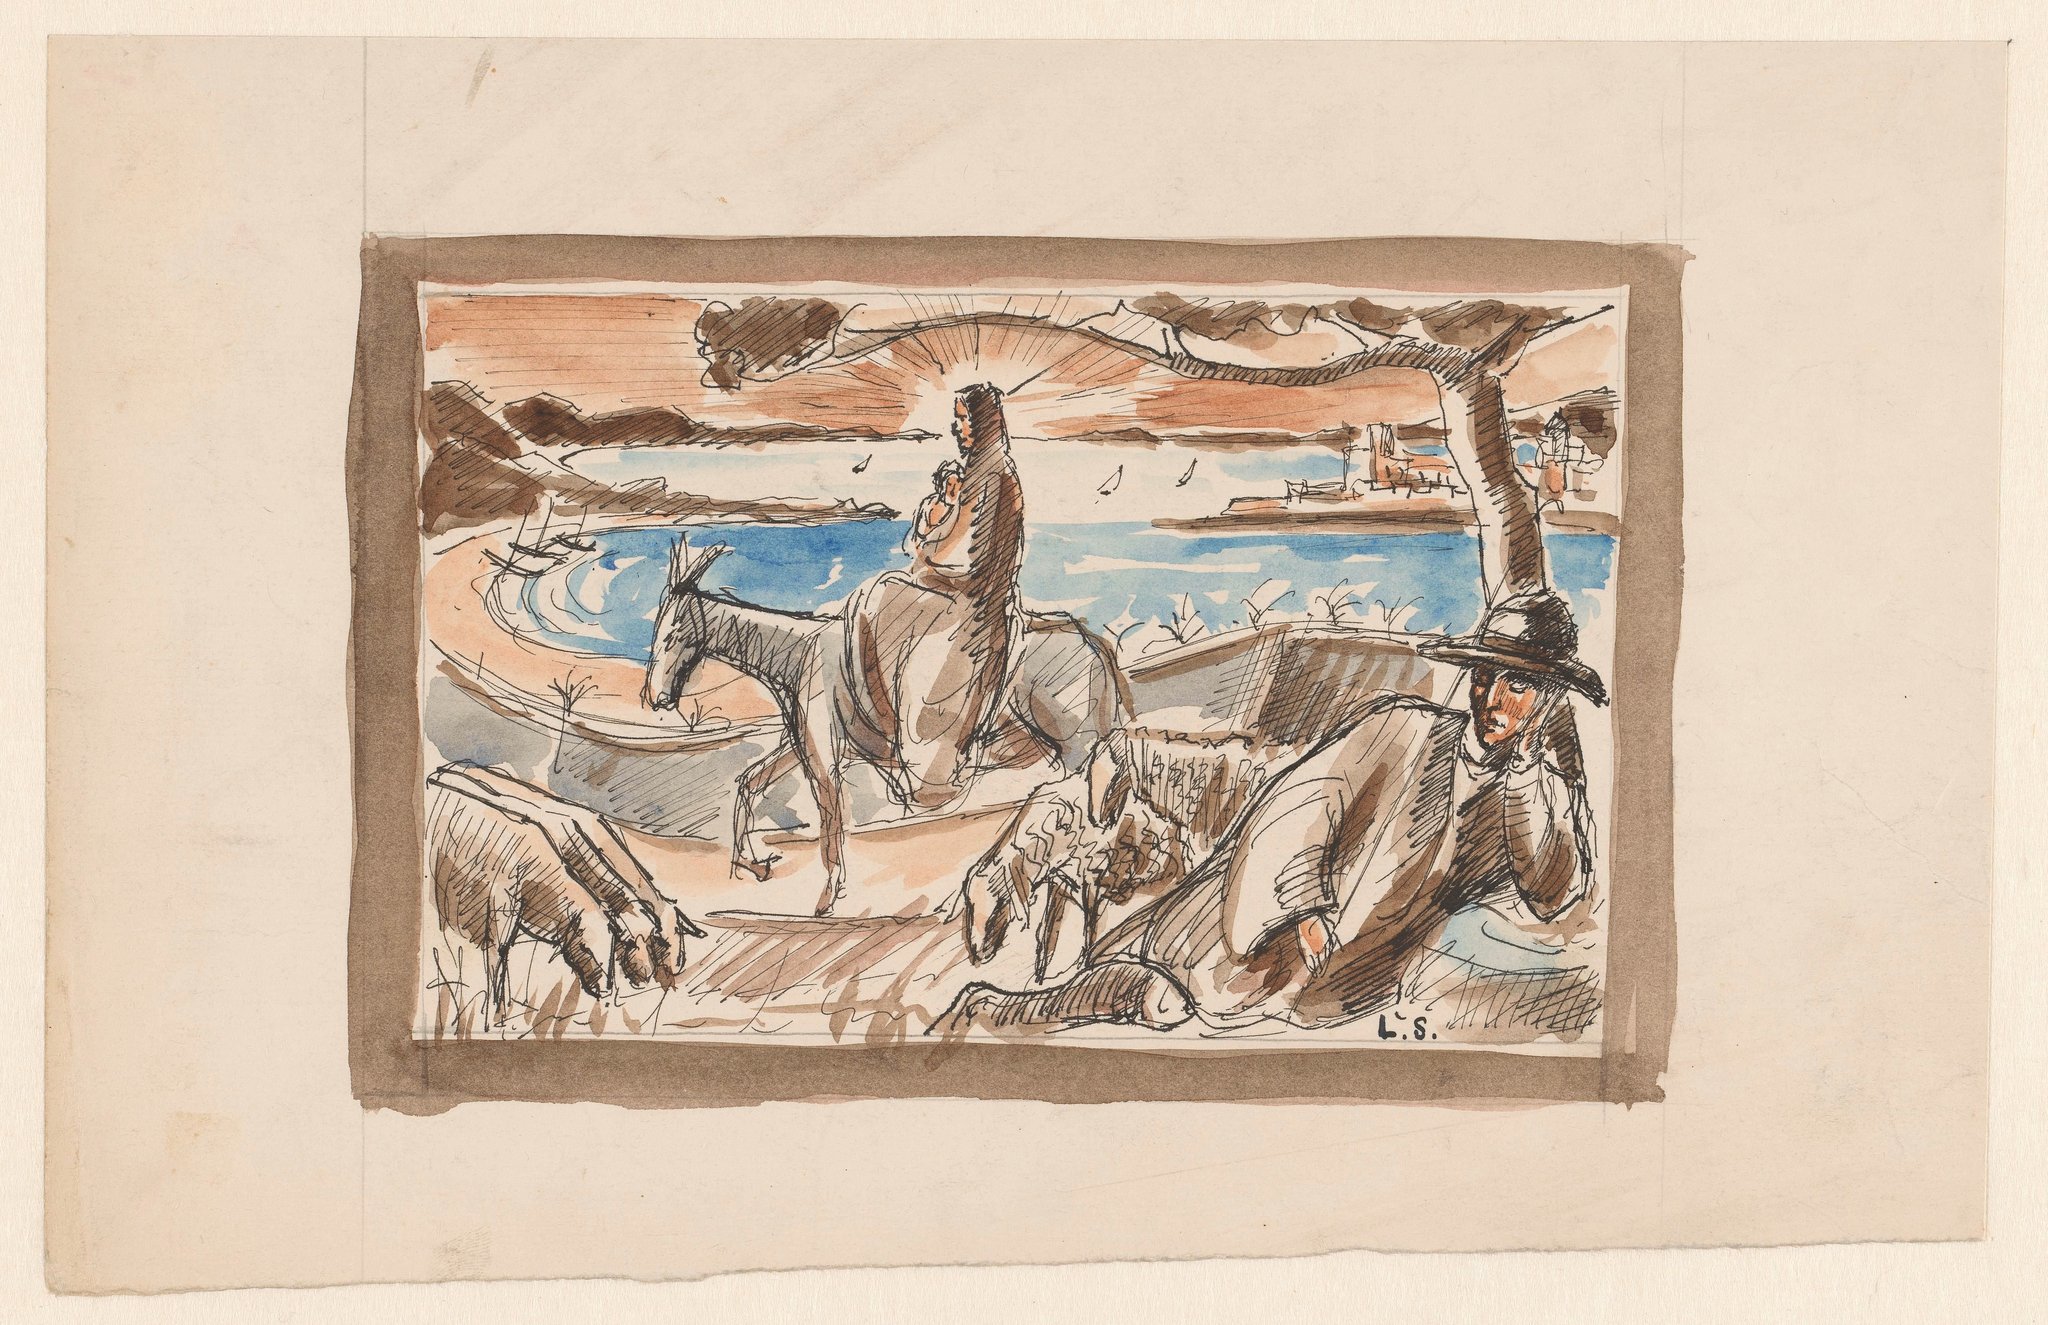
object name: drawing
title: Vlucht naar Egypte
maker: lodewijk schelfhout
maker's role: draughtsman, print maker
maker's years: 1881-1943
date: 1891-1943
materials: ink, paper, pencil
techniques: brush, pen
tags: sheep, the flight into egypt: mary, joseph, the child (and sometimes others) on their way; mary usually riding on an ass - bb - landscape predominant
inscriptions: collector's mark: Lugt 2228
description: Maria rijdt met Christus op een ezel in een kustlandschap. Ze passeren een paar schapen en een man die tegen een boom leunt.